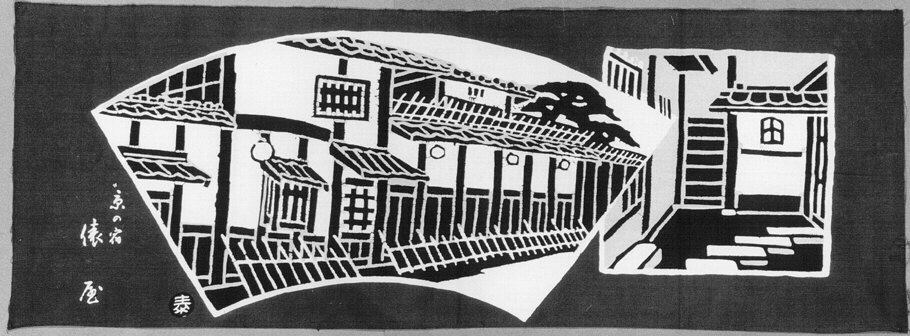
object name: strip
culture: japanese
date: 1901-1950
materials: cotton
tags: buildings